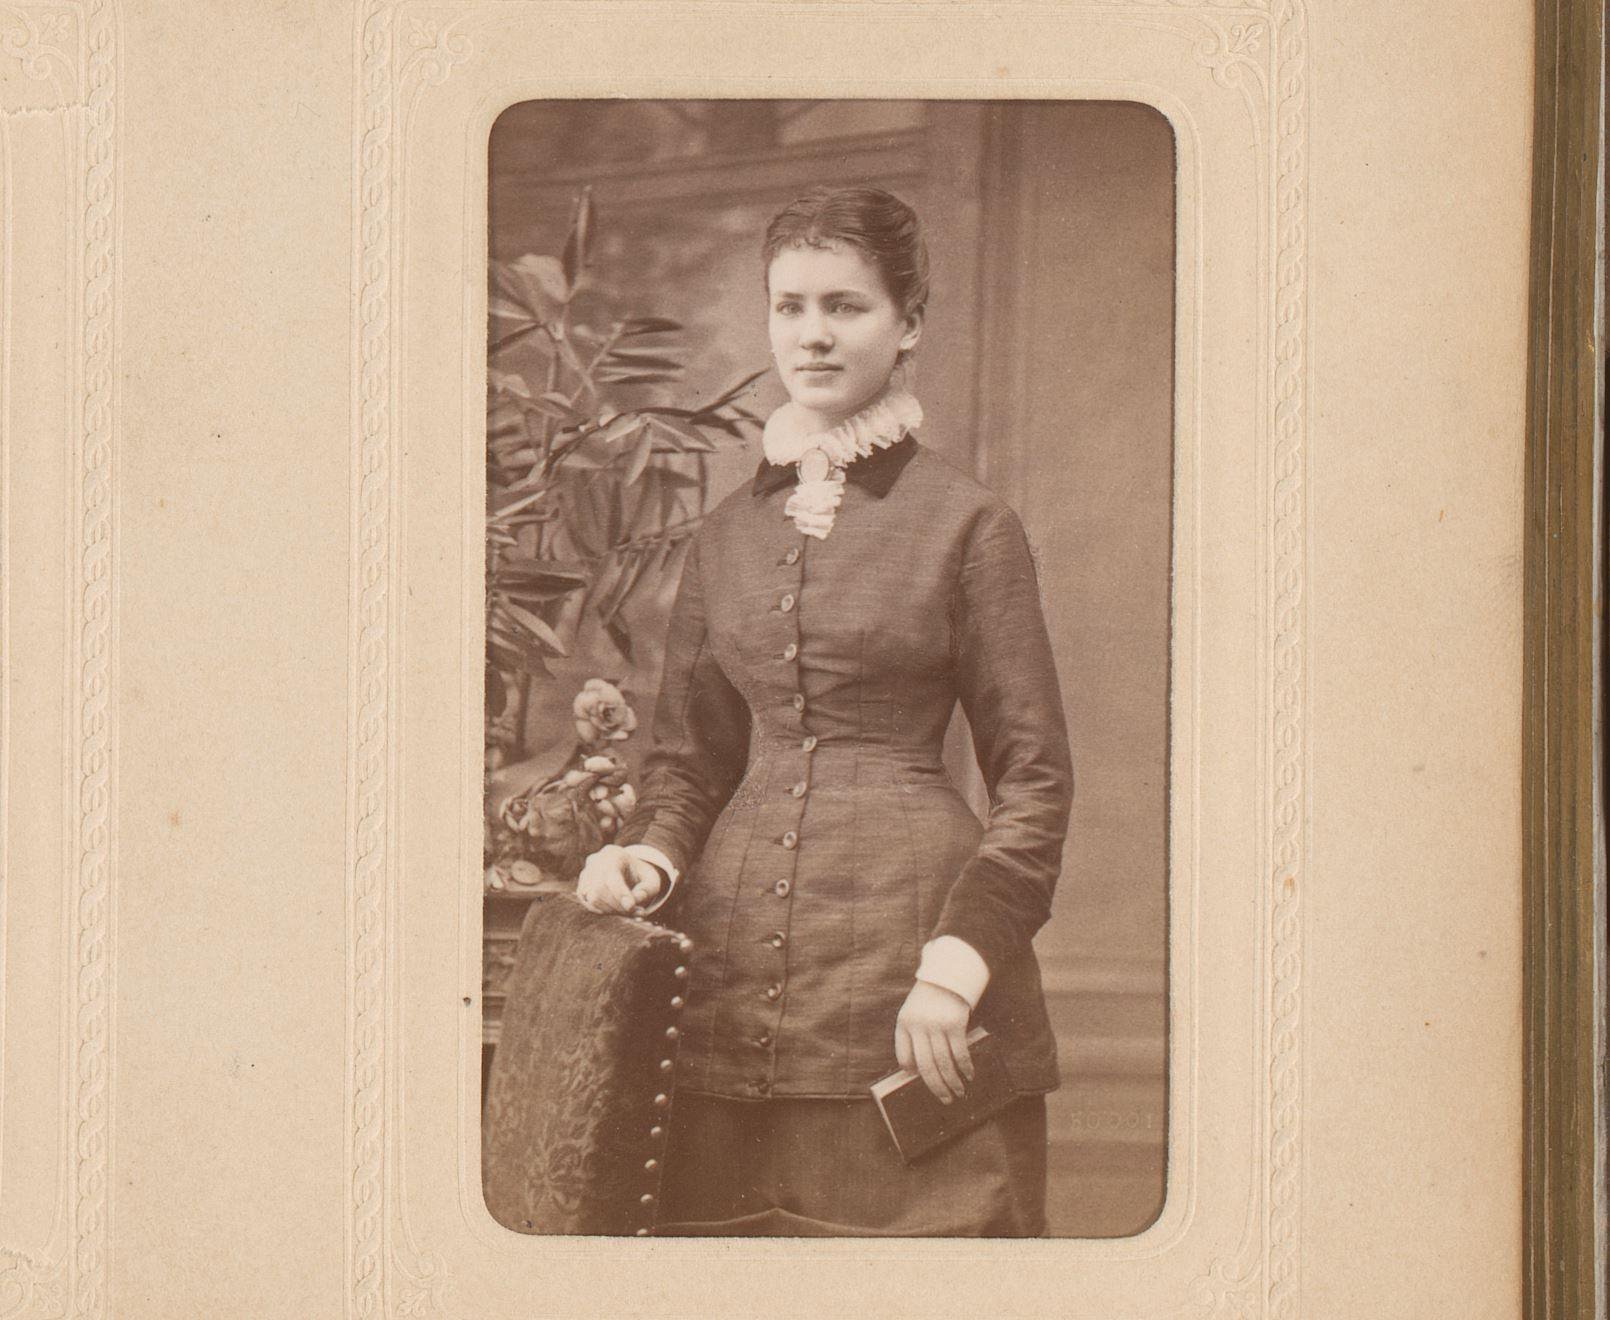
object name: carte de visite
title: Portret van een jonge vrouw met boek in de hand, staand bij een stoel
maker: josef ungar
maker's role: painter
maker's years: 1869-1907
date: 1884-1900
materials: cardboard, photographic support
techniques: albumen print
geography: vienna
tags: adolescent, young woman, maiden, historical persons - bb - woman, book, standing figure - aa - female human figure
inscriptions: inscription: ‘(...)/ PHOTOGRAPH. ARTIST. ATELIER/ J. UNGAR/ WIEN/ Strauchgasse, Palais, Montenuovo./ (...)’